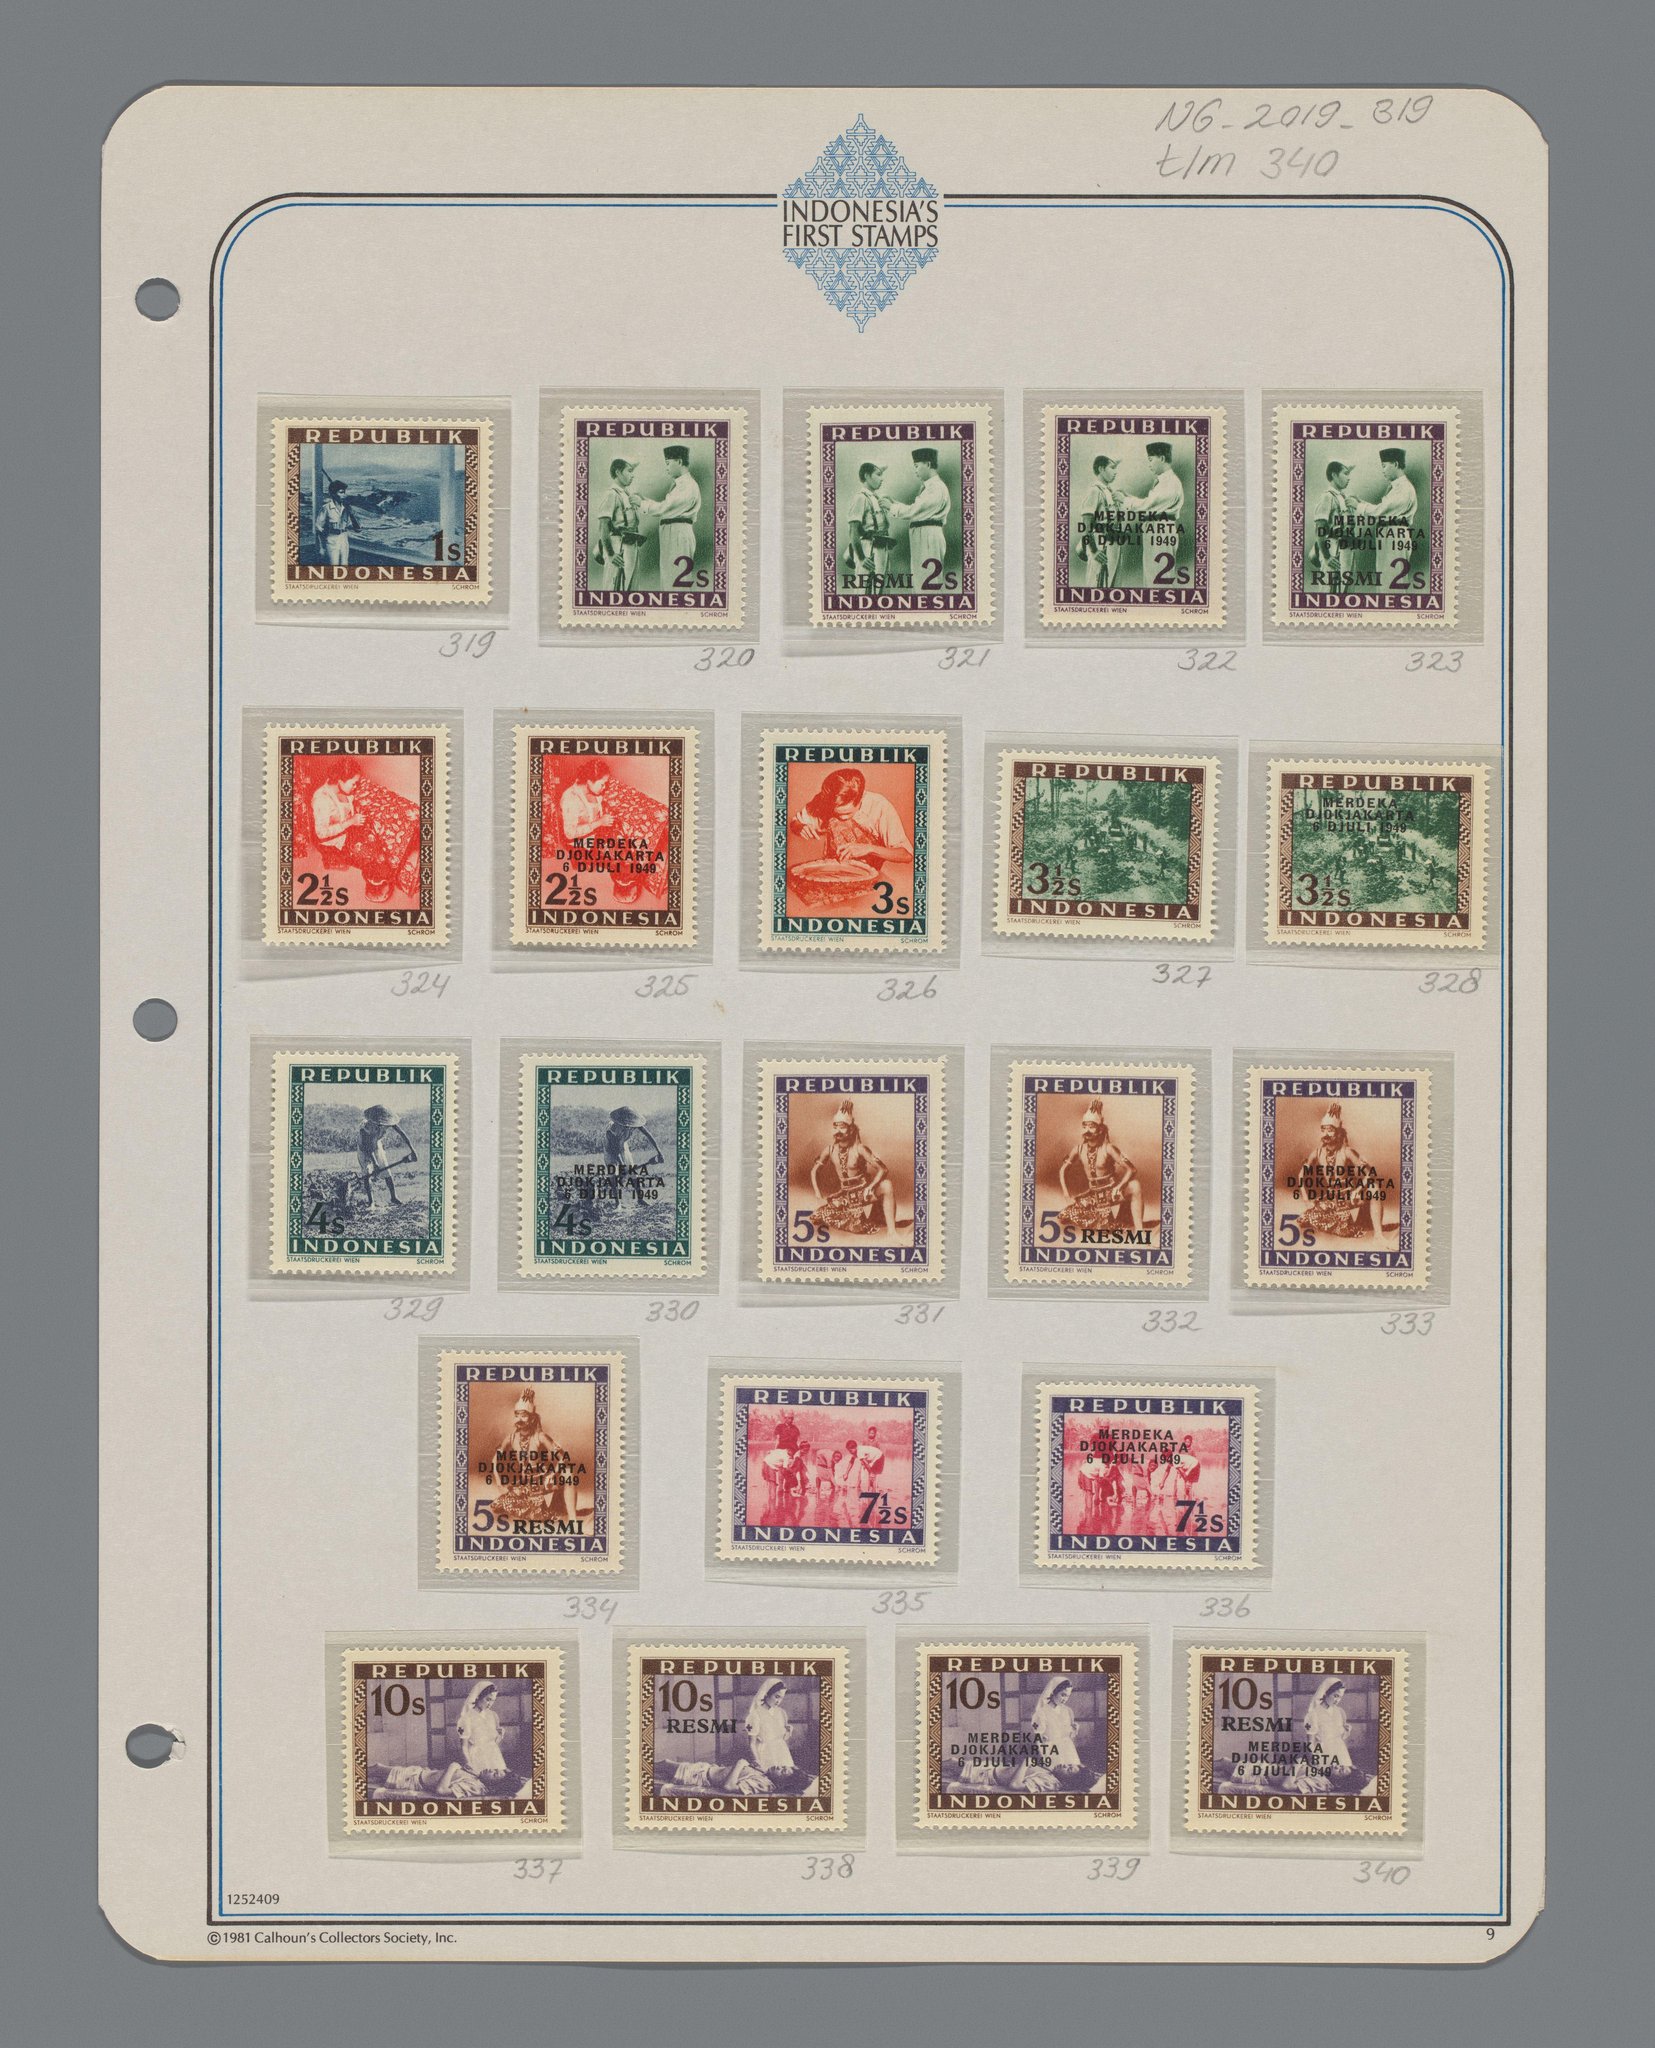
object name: postage stamp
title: Postzegel Republik Indonesia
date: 1949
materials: paper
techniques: photoaquatint, engraving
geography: philadelphia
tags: indonesia